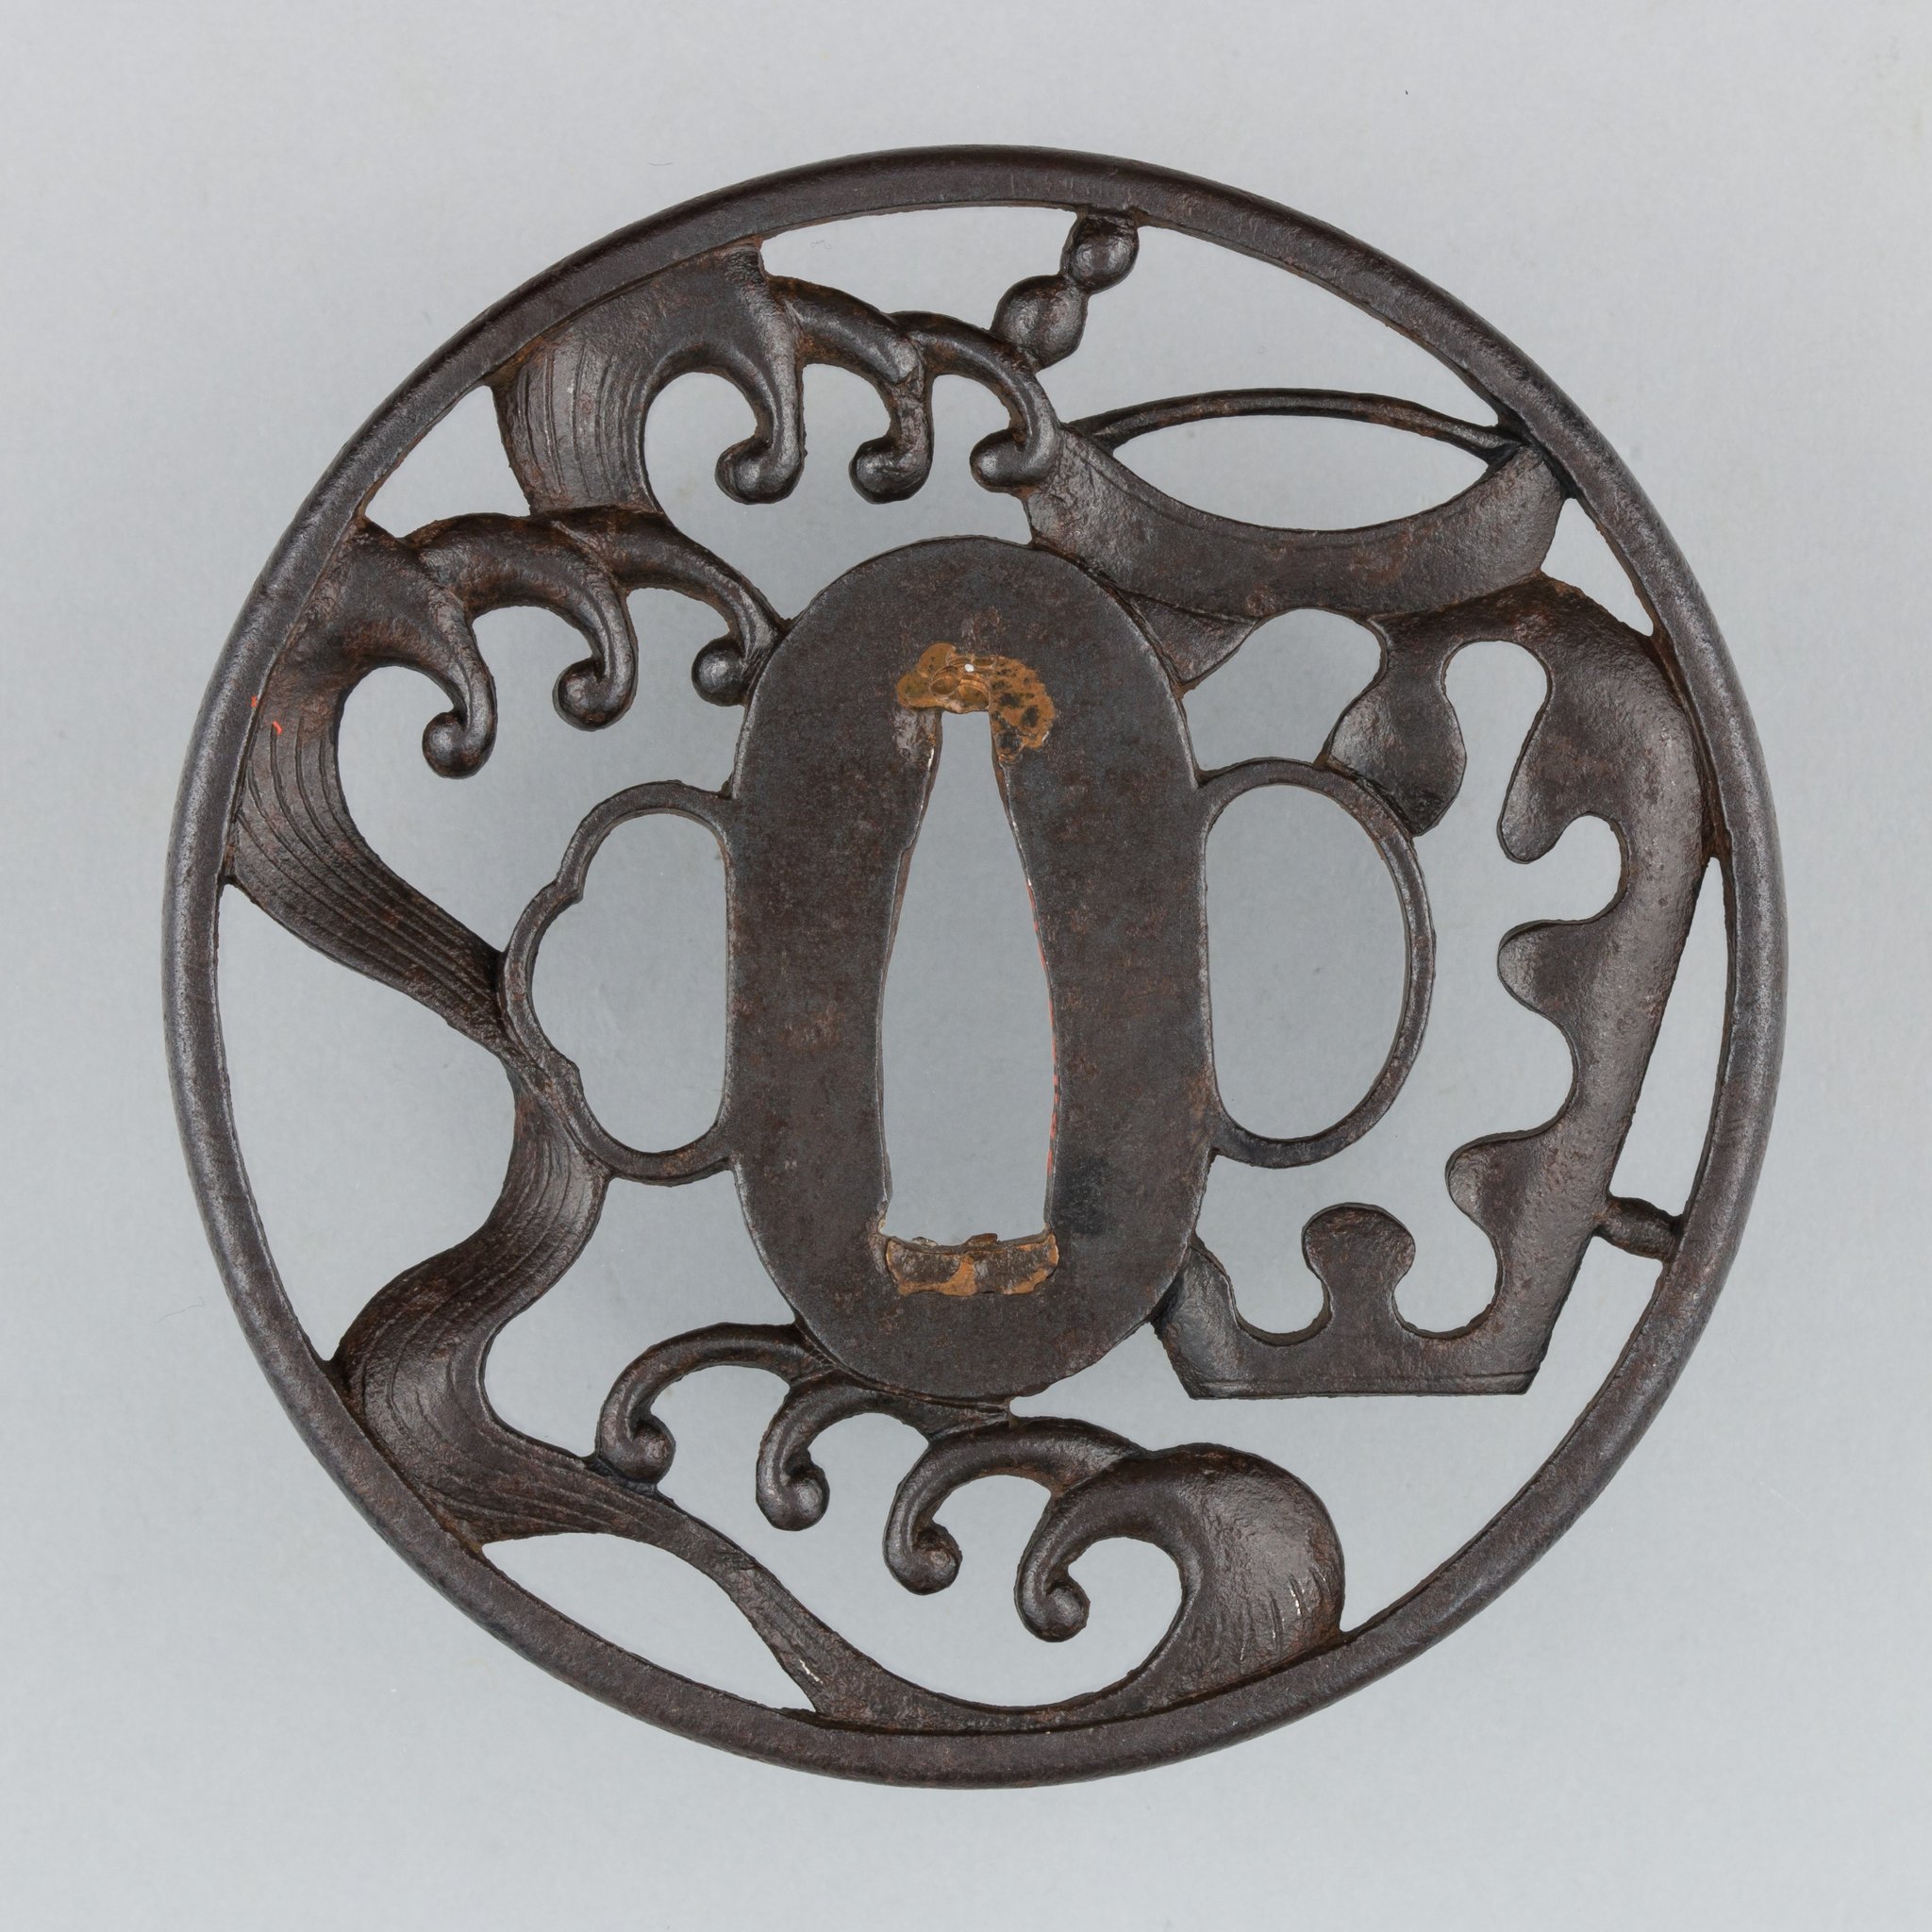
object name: sword guard tsuba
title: Sword Guard (Tsuba)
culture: japanese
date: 1701-1733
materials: copper, iron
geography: japan